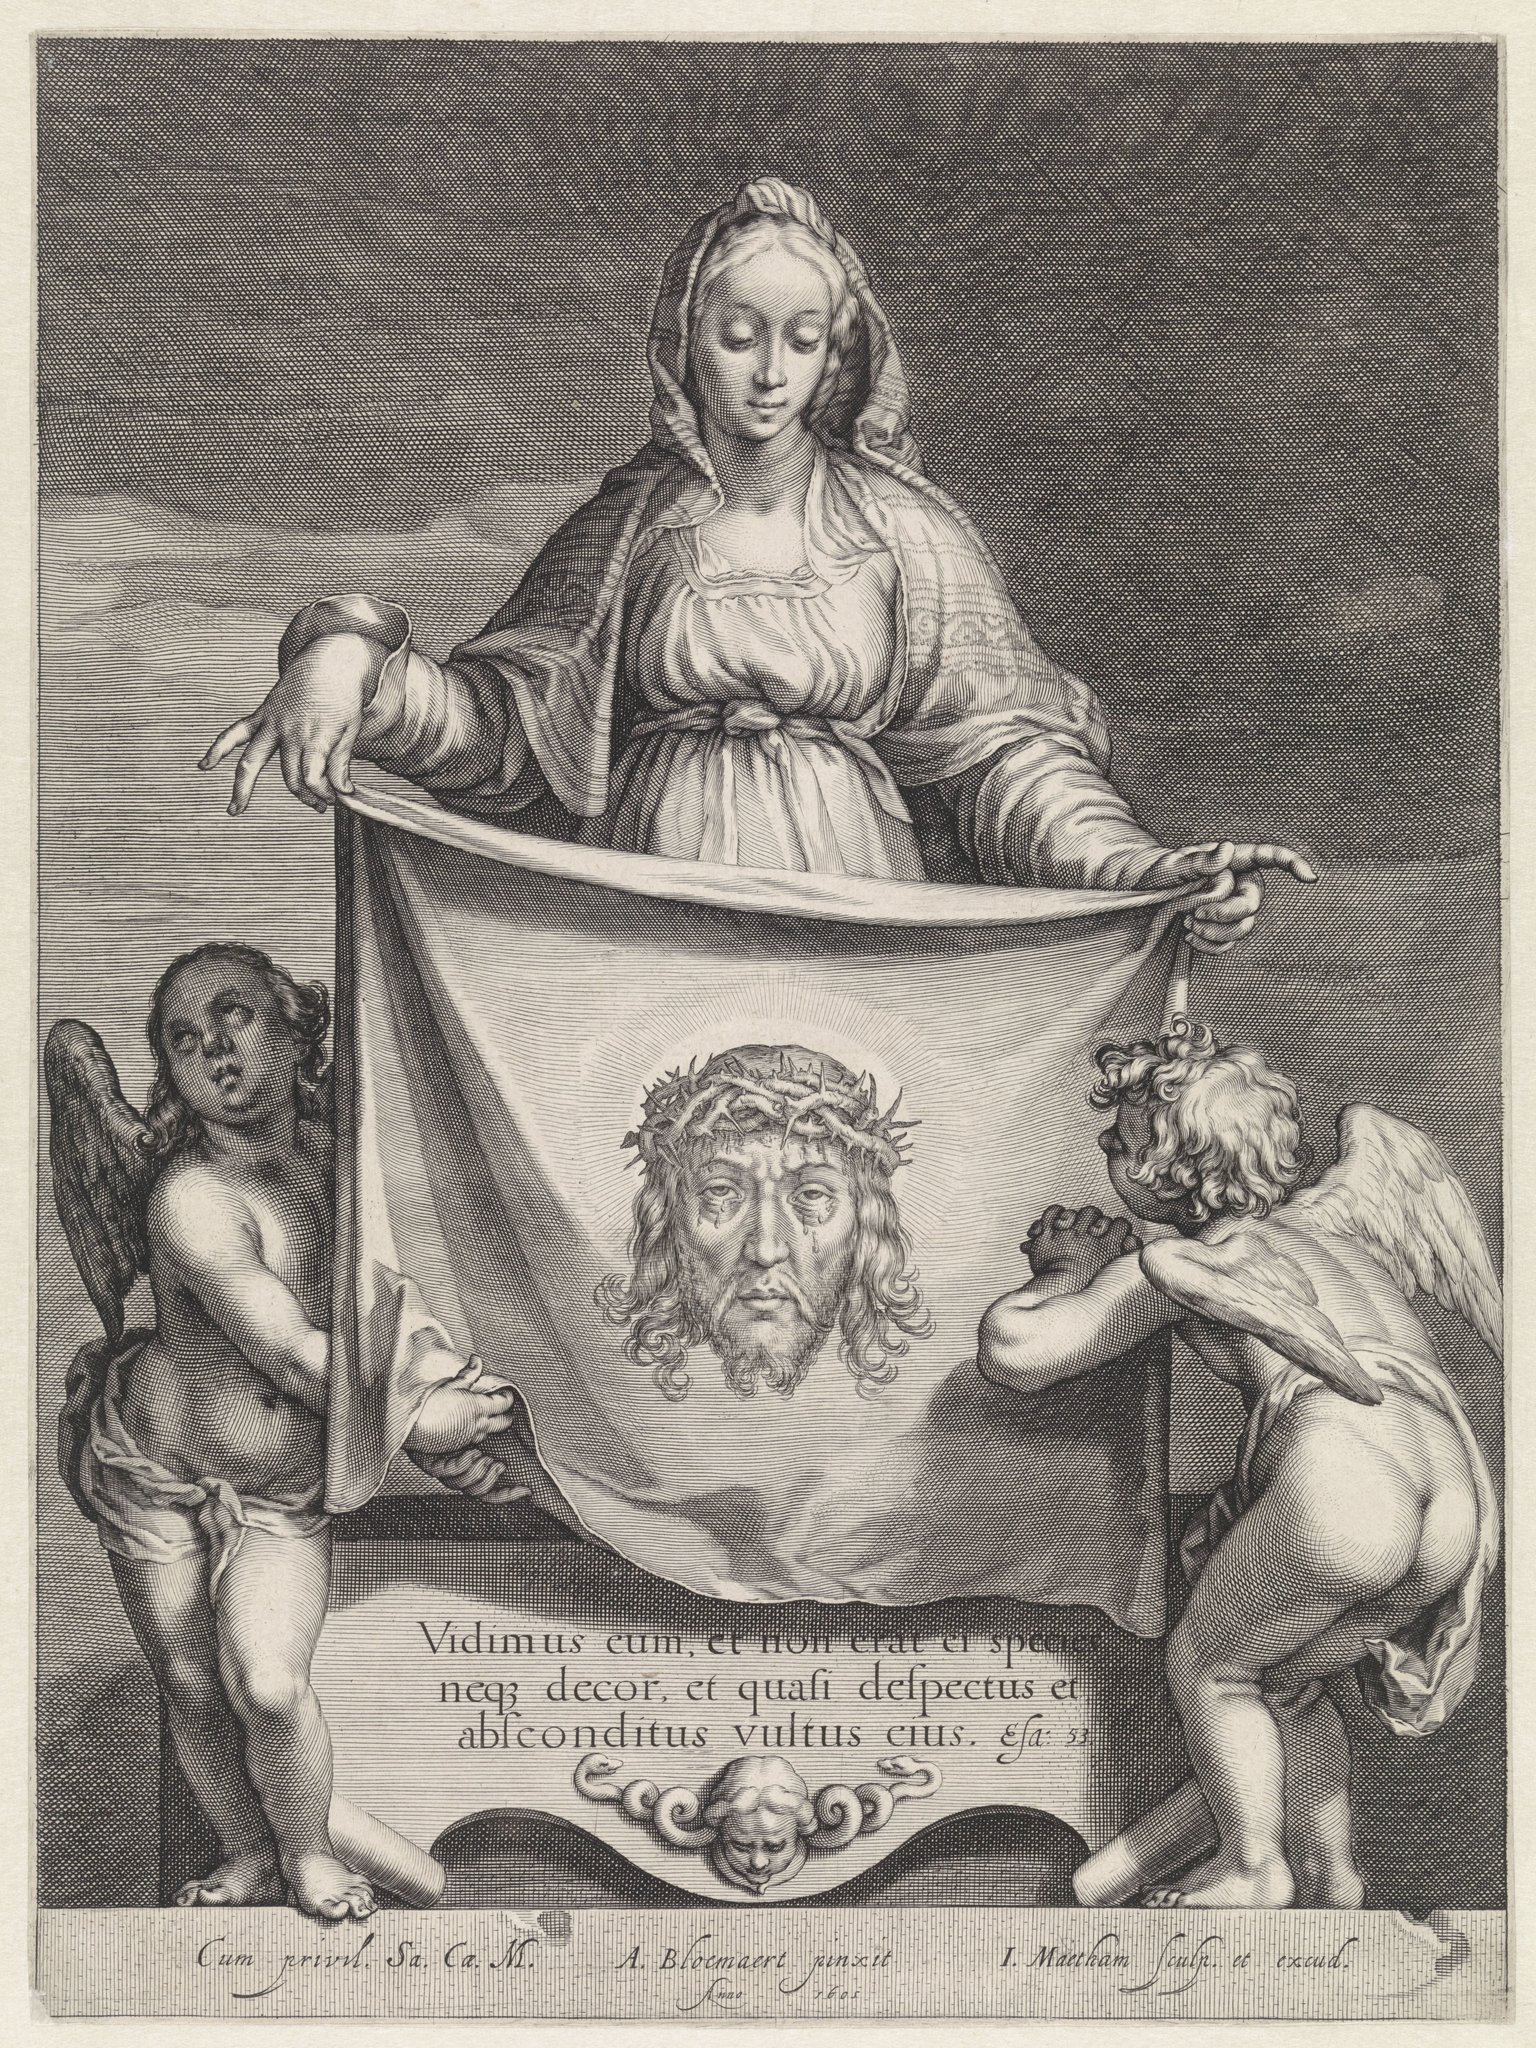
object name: print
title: H. Veronica met de zweetdoek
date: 1605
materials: paper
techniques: engraving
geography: haarlem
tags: veronica; possible attributes: 'sudarium' (veil with the image of christ) (+ angel(s)), 'vera icon', held up by veronica (+ angel(s))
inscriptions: collector's mark: Lugt 240